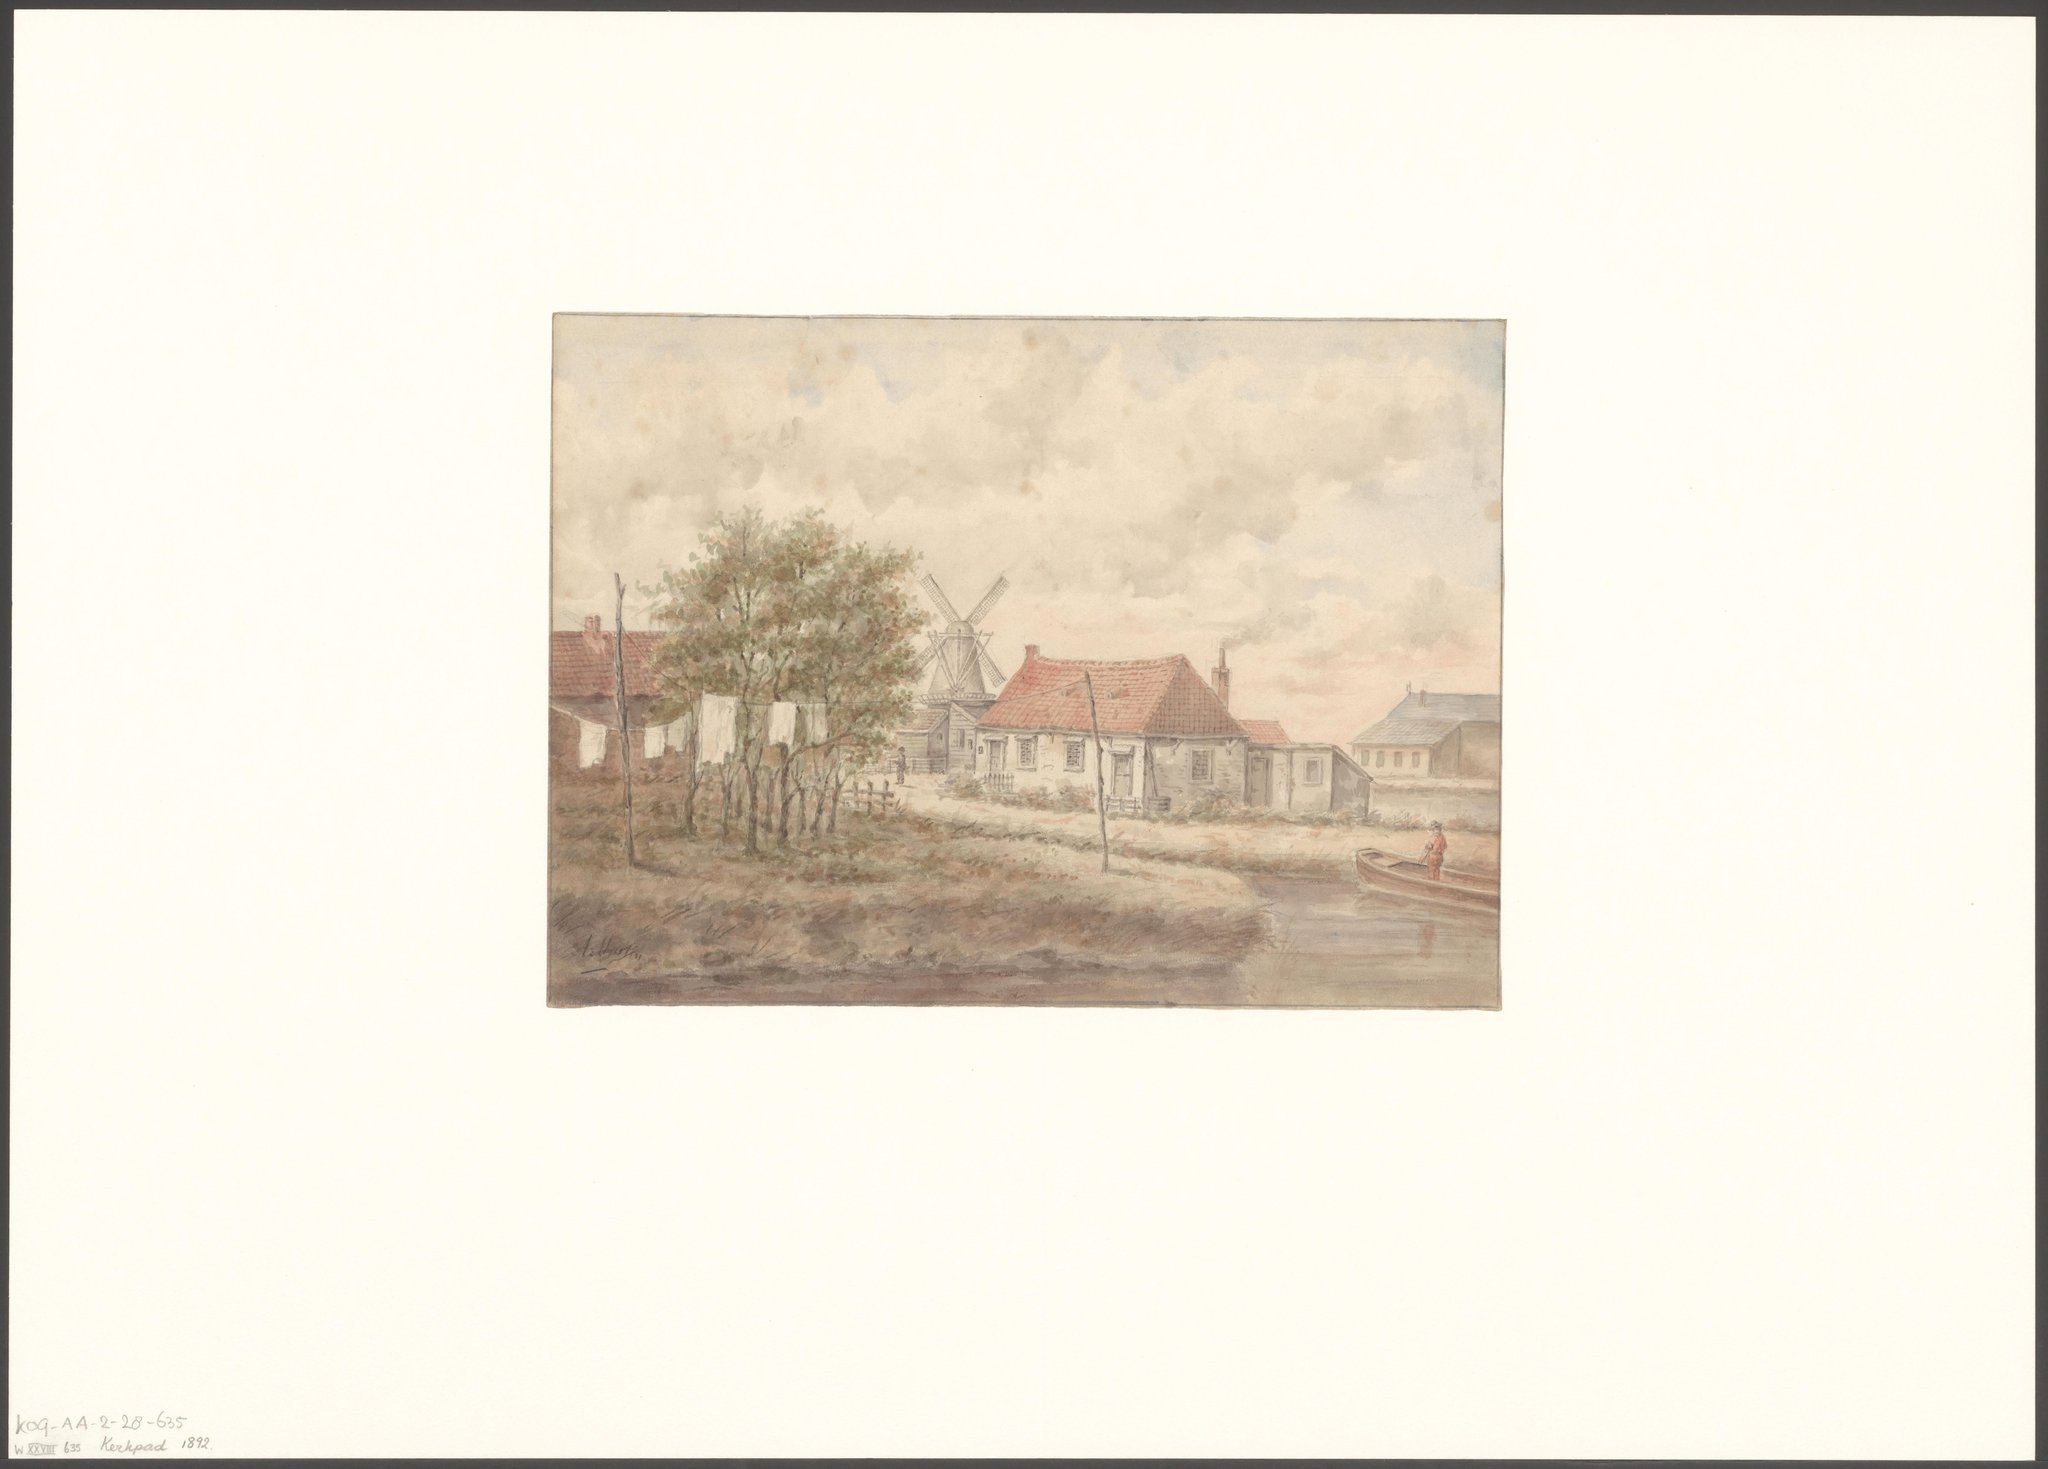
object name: drawing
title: Gezicht op het Kerkpad vanaf de Lijnbaansgracht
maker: albert martin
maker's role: draughtsman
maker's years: 1827-1900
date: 1892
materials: paper, pencil, watercolor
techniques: brush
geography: amsterdam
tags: city-view in general; 'veduta', canal, windmill in landscape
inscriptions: signature: ‘A.Martin’, collector's mark: Lugt 800a, inscription: ‘Gezicht aan de Lijnbaan / op het Kerkpad 1892’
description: Tekening binnen de Atlas Van Eck ingedeeld op wijknummer 28.